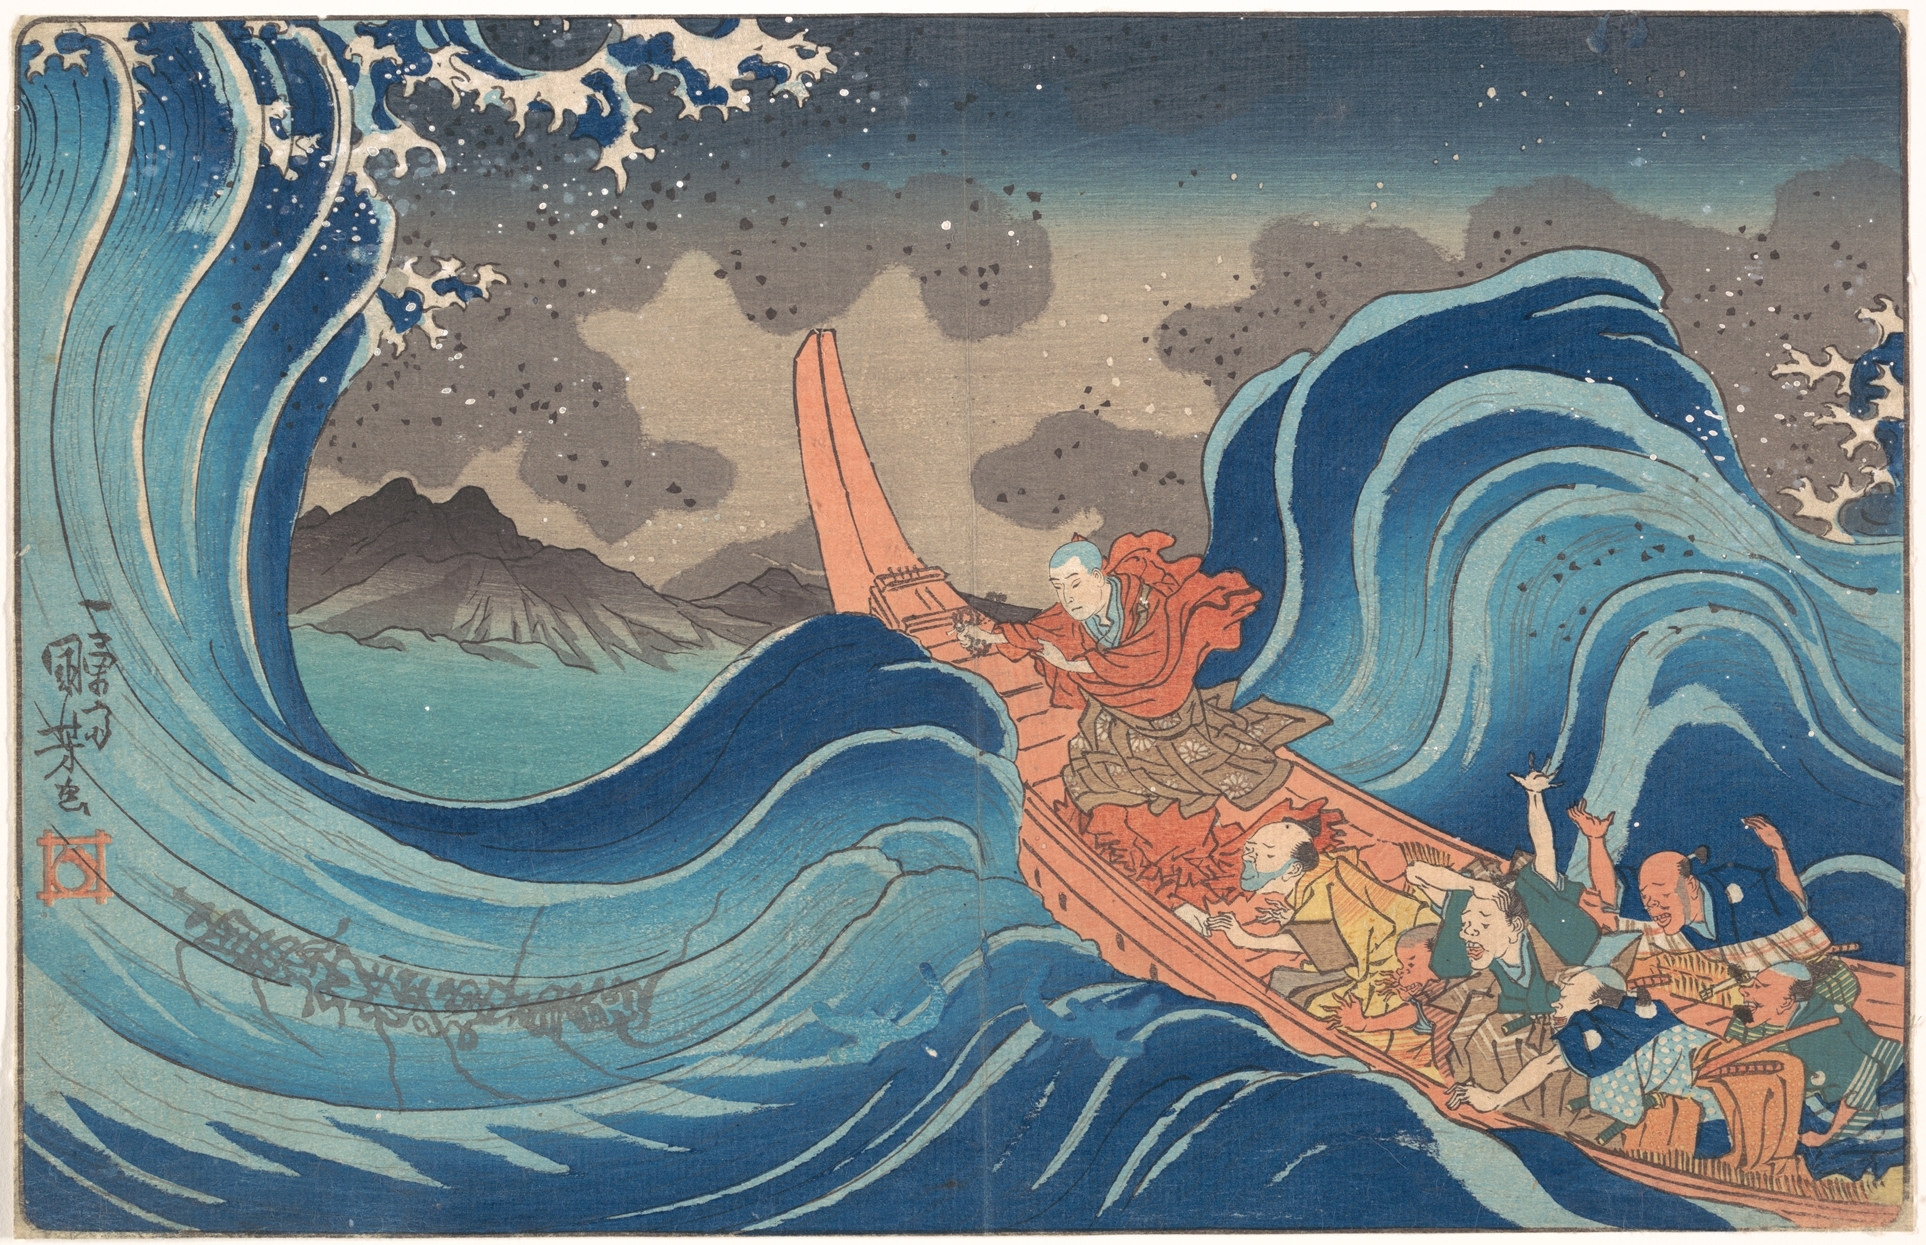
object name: print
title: Concise Illustrated Biography of Monk Nichiren: Calming the Stormy Sea at Tsunoda in Exile to Sado Island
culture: japanese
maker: utagawa kuniyoshi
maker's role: artist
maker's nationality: japanese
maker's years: 1797-1861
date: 1835-1836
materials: ink, paper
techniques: woodblock print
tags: men,waves,boats